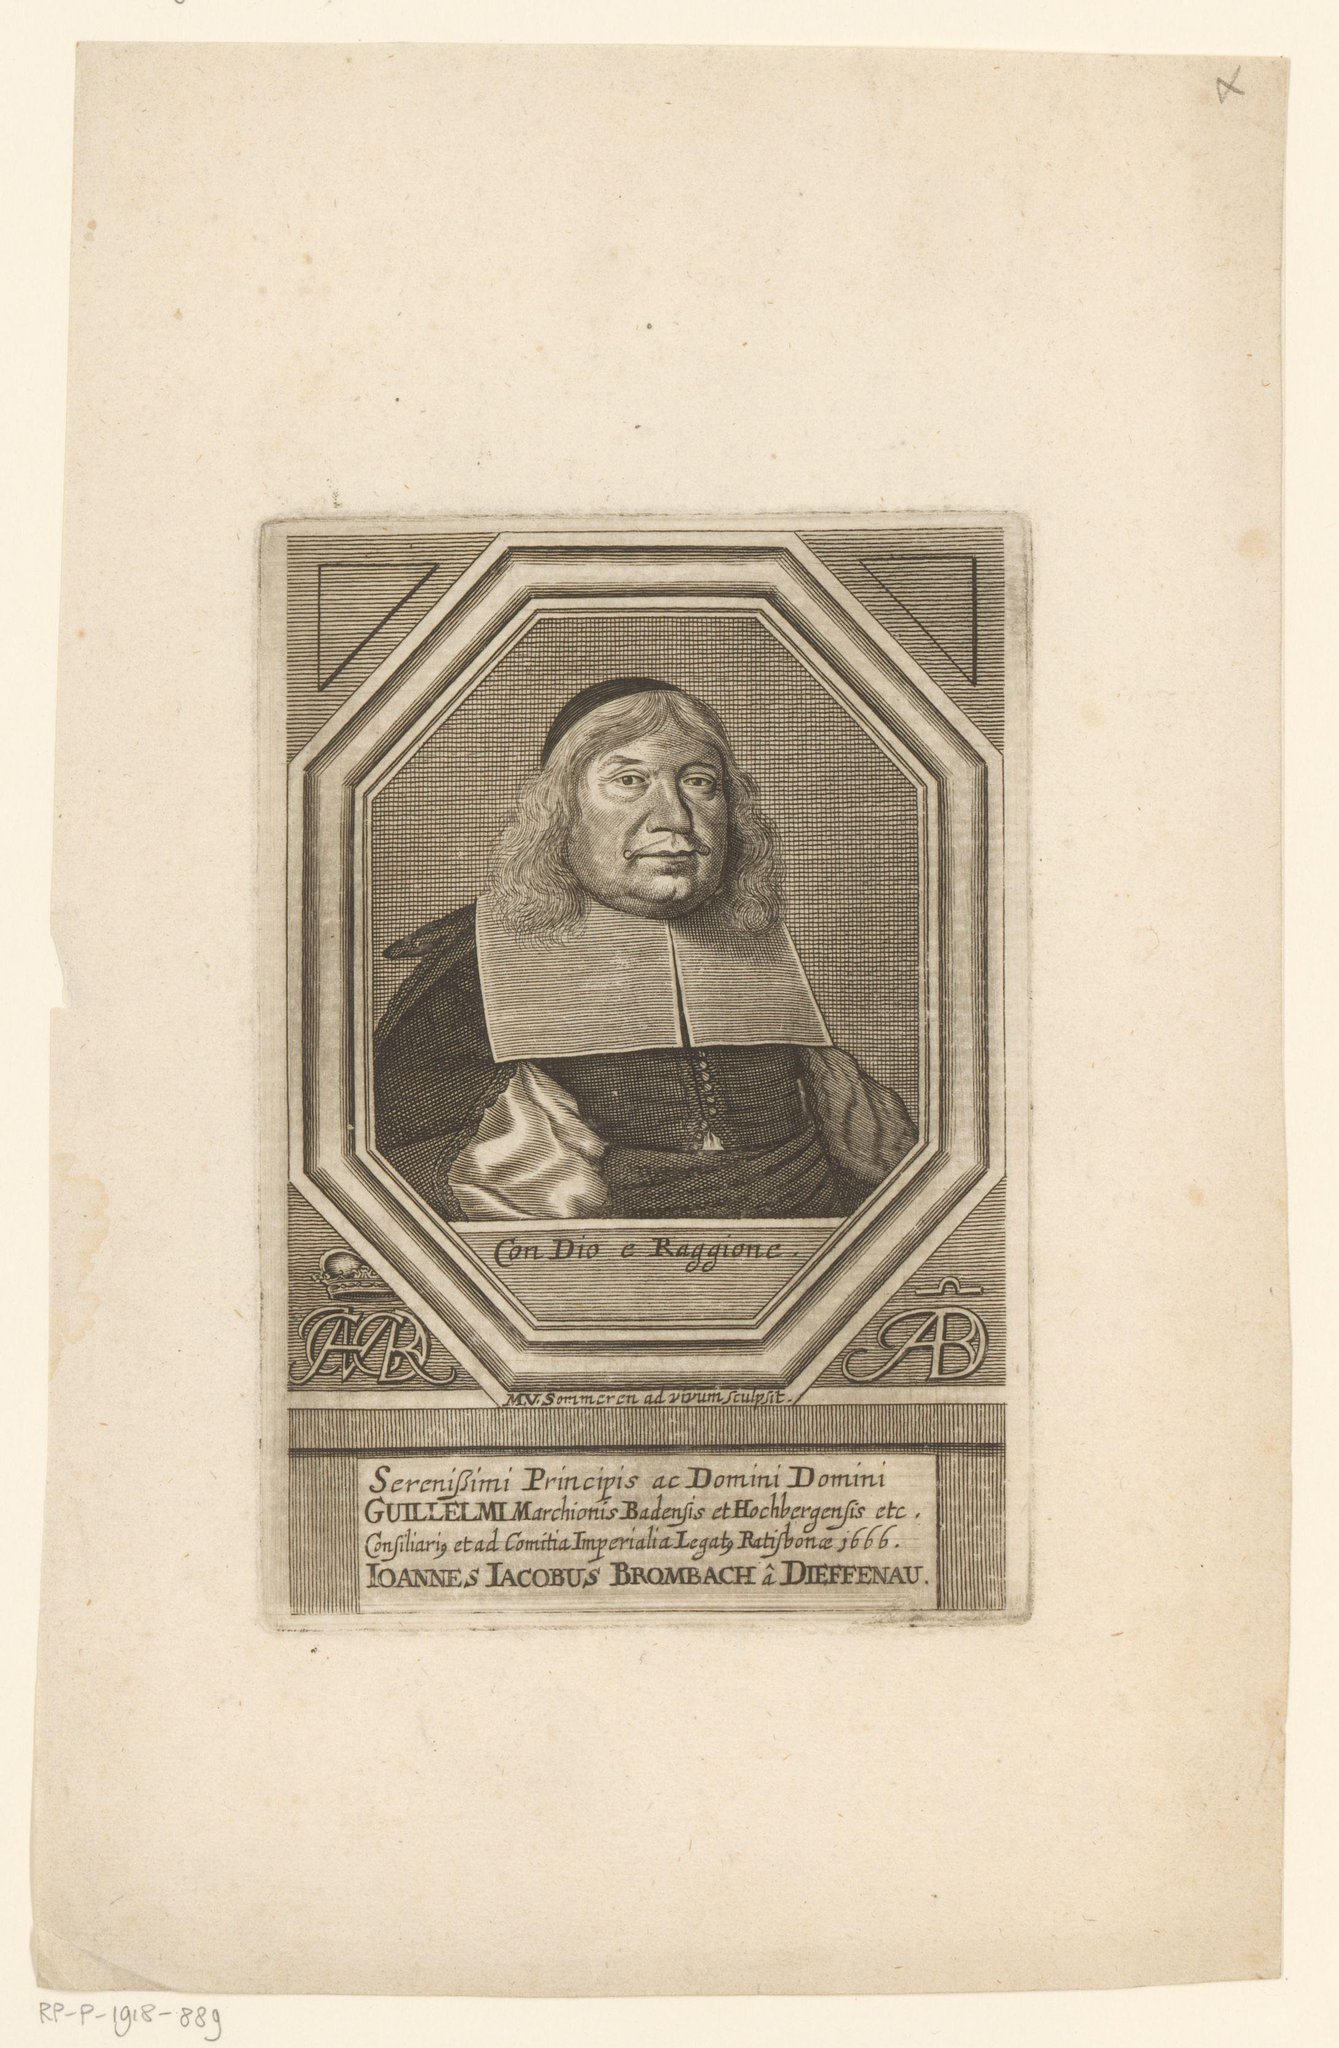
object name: print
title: Portret van Johann Jacob Brombach von Dieffenau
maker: matthias van sommer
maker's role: draughtsman, print maker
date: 1666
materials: paper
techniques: engraving, etching, intaglio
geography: germany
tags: historical persons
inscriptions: collector's mark: Lugt 2233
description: Volgens Hollstein werd de prent gebruikt voor de publicatie: Sommer, Matthias van. Hasce Omnium Electorum. Regensburg: s.n., 1667. Alhoewel op de titelpagina van de publicatie het jaar 1667 wordt vermeld, zijn meerdere prenten later gedateerd. Waarschijnlijk werd de publicatie pas in 1671 daadwerkelijk uitgegeven.